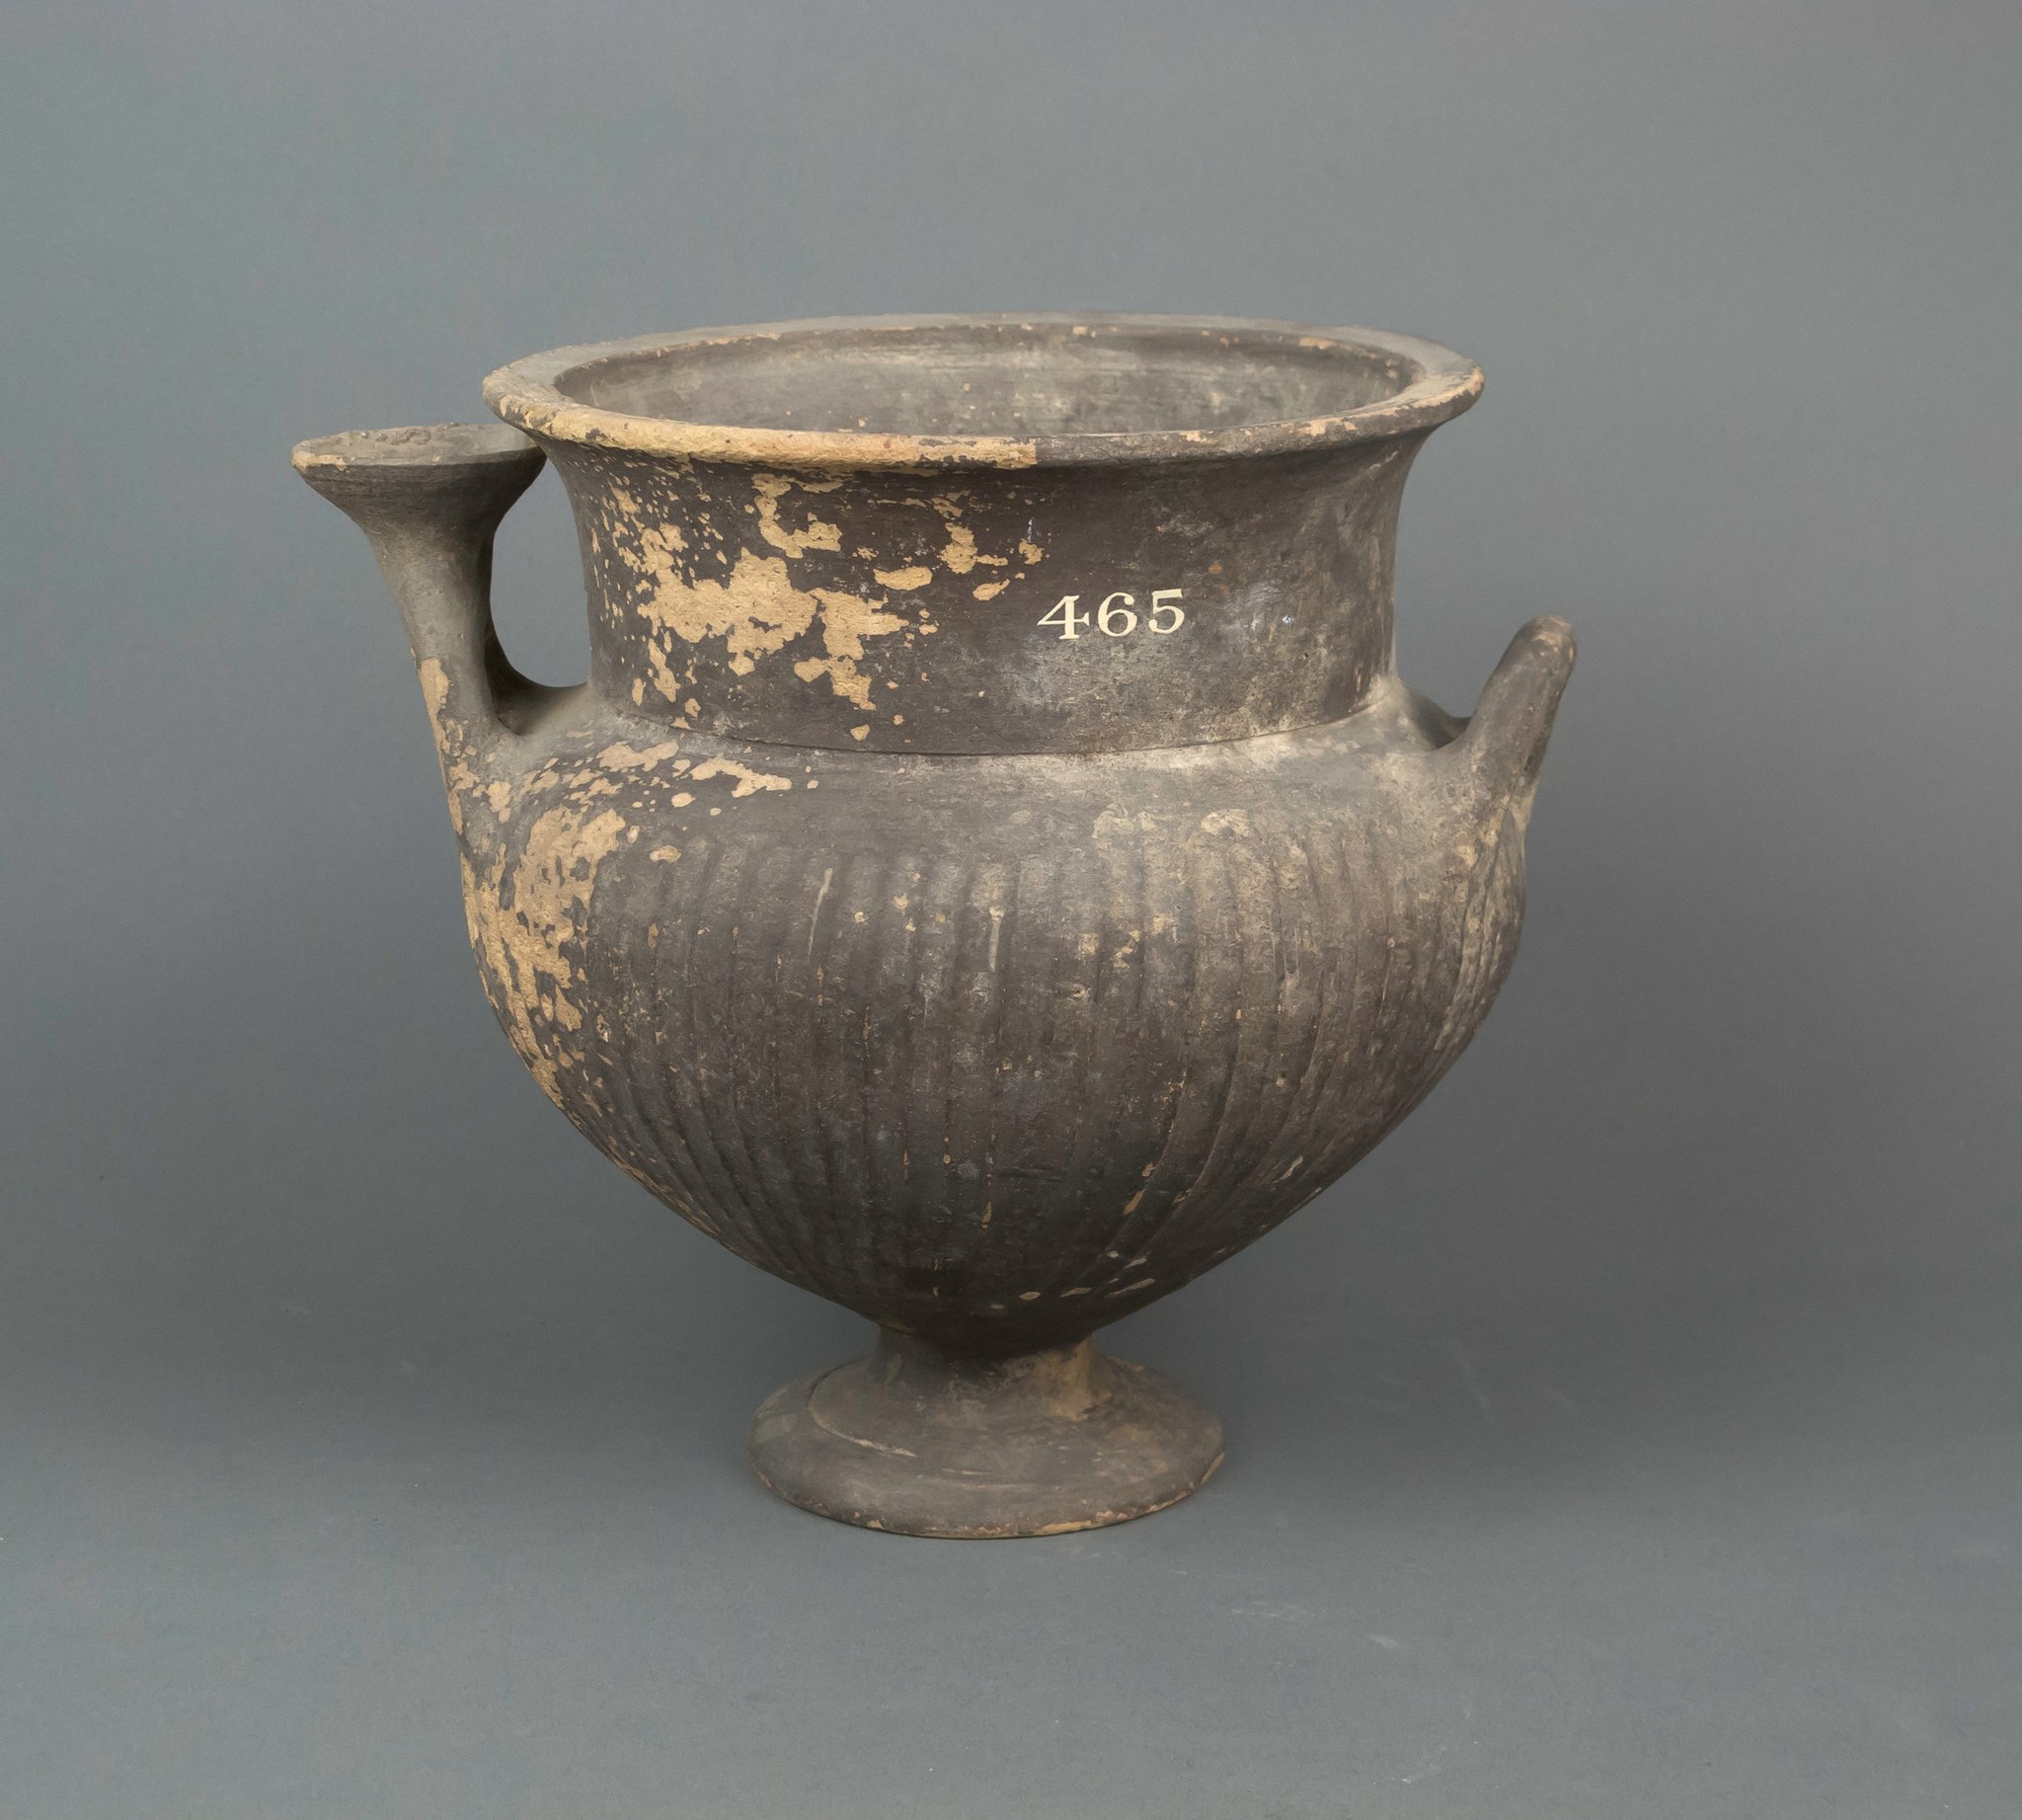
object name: krater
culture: cypriot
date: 1050-950 BCE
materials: terracotta